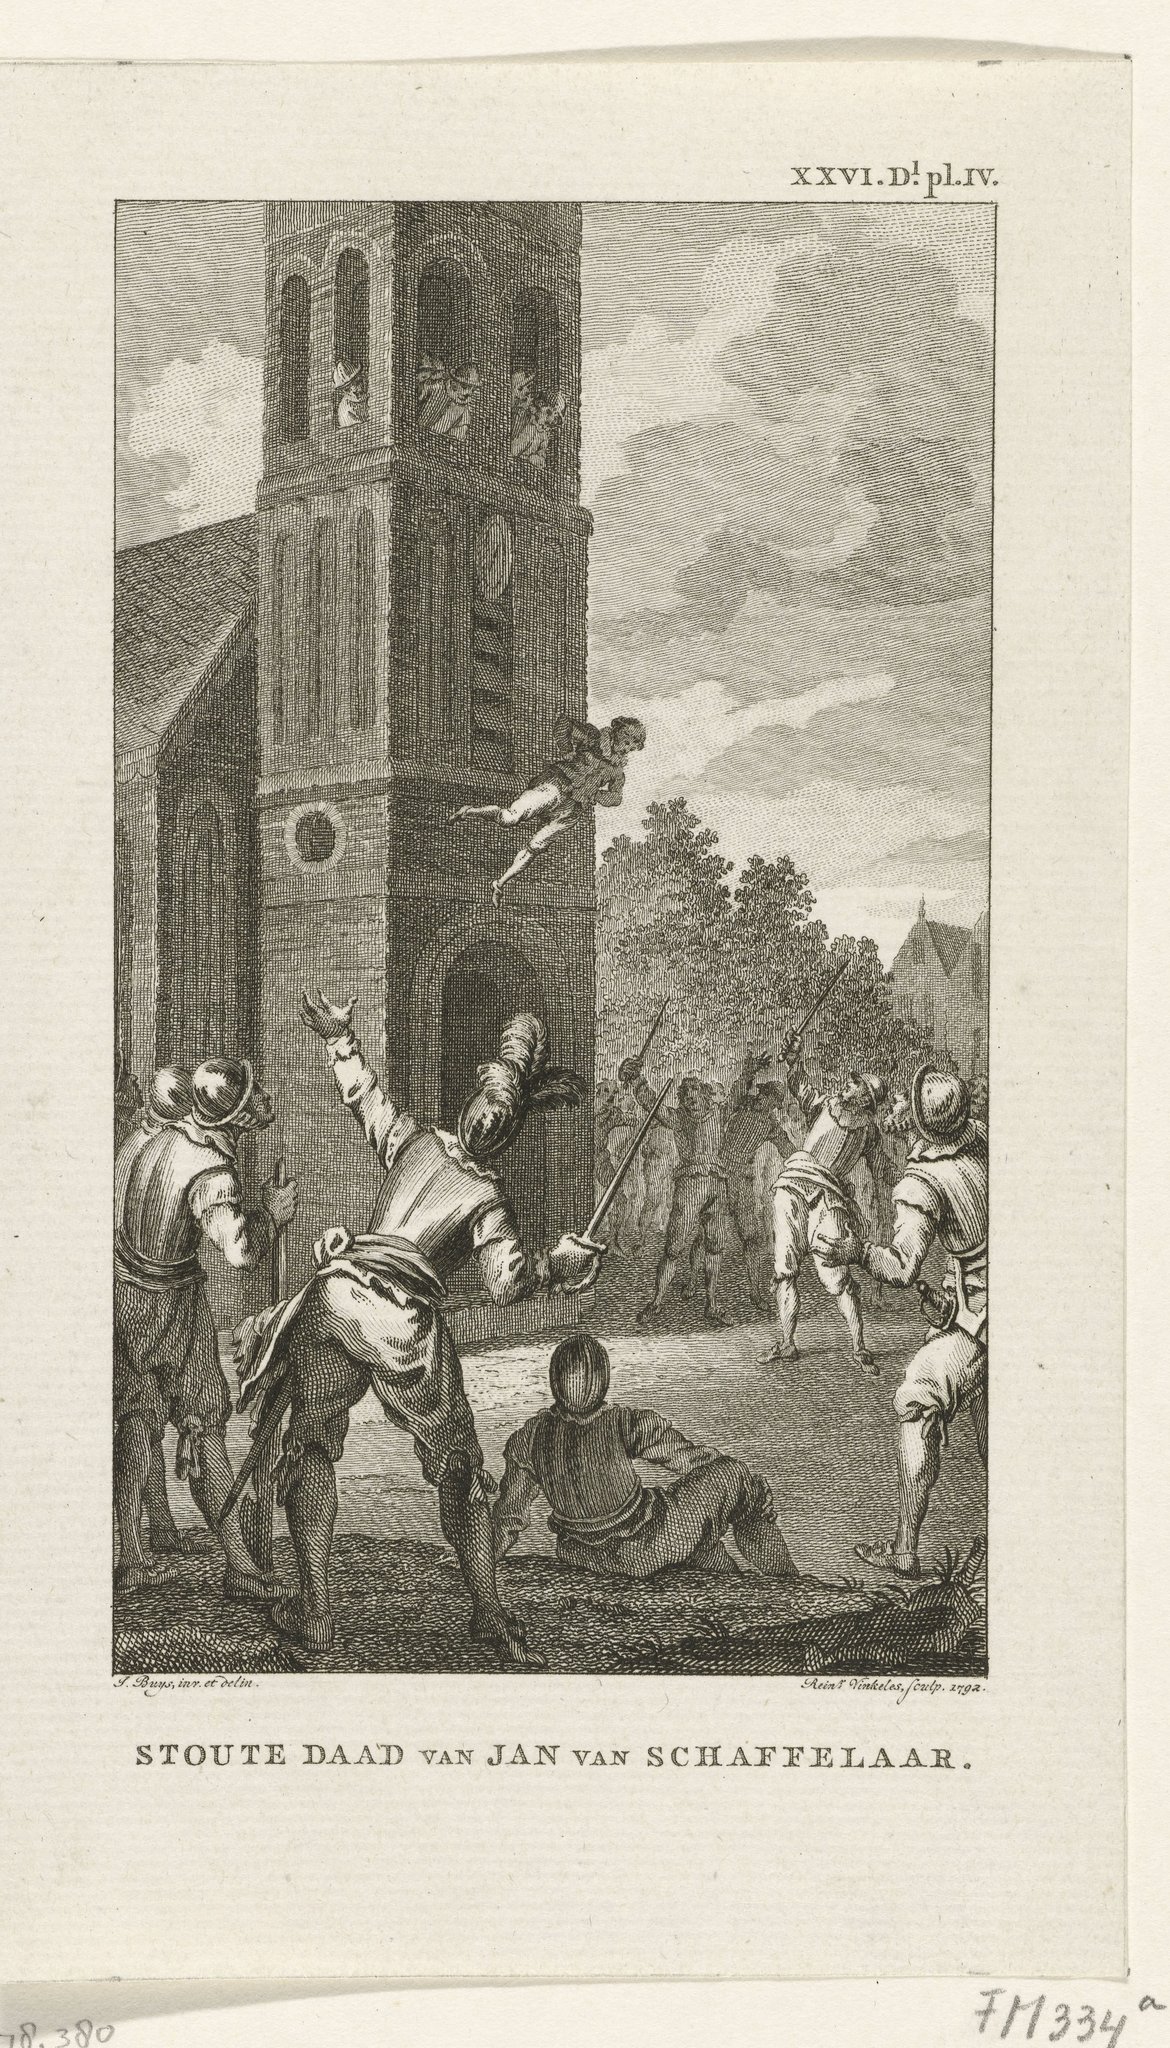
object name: print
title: Stoute daad van Jan van Schaffelaar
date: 1792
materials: paper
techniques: etching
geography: netherlands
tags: self-sacrifice, death in the service of a higher purpose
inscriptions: date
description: Illustratie voor: Jacobus Kok, Vaderlandsch Woordenboek, Johannes Allart, Amsterdam 1785-1799, 35 delen, dl. XXVI, pl. IV. Staat met de letter.